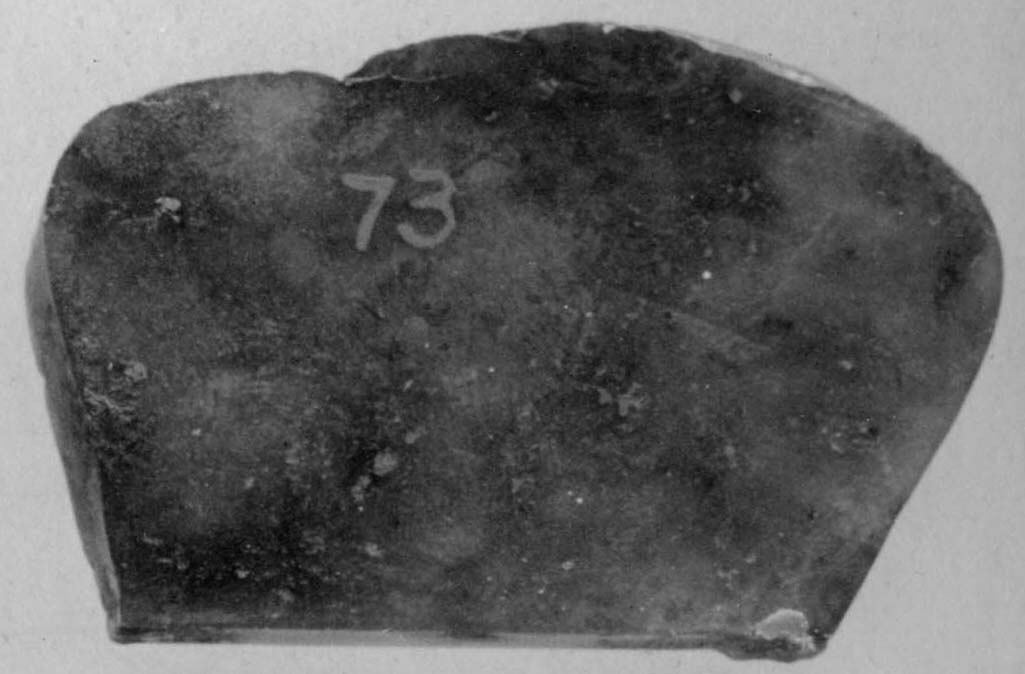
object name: fragment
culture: chinese or turkestani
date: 1902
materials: jade